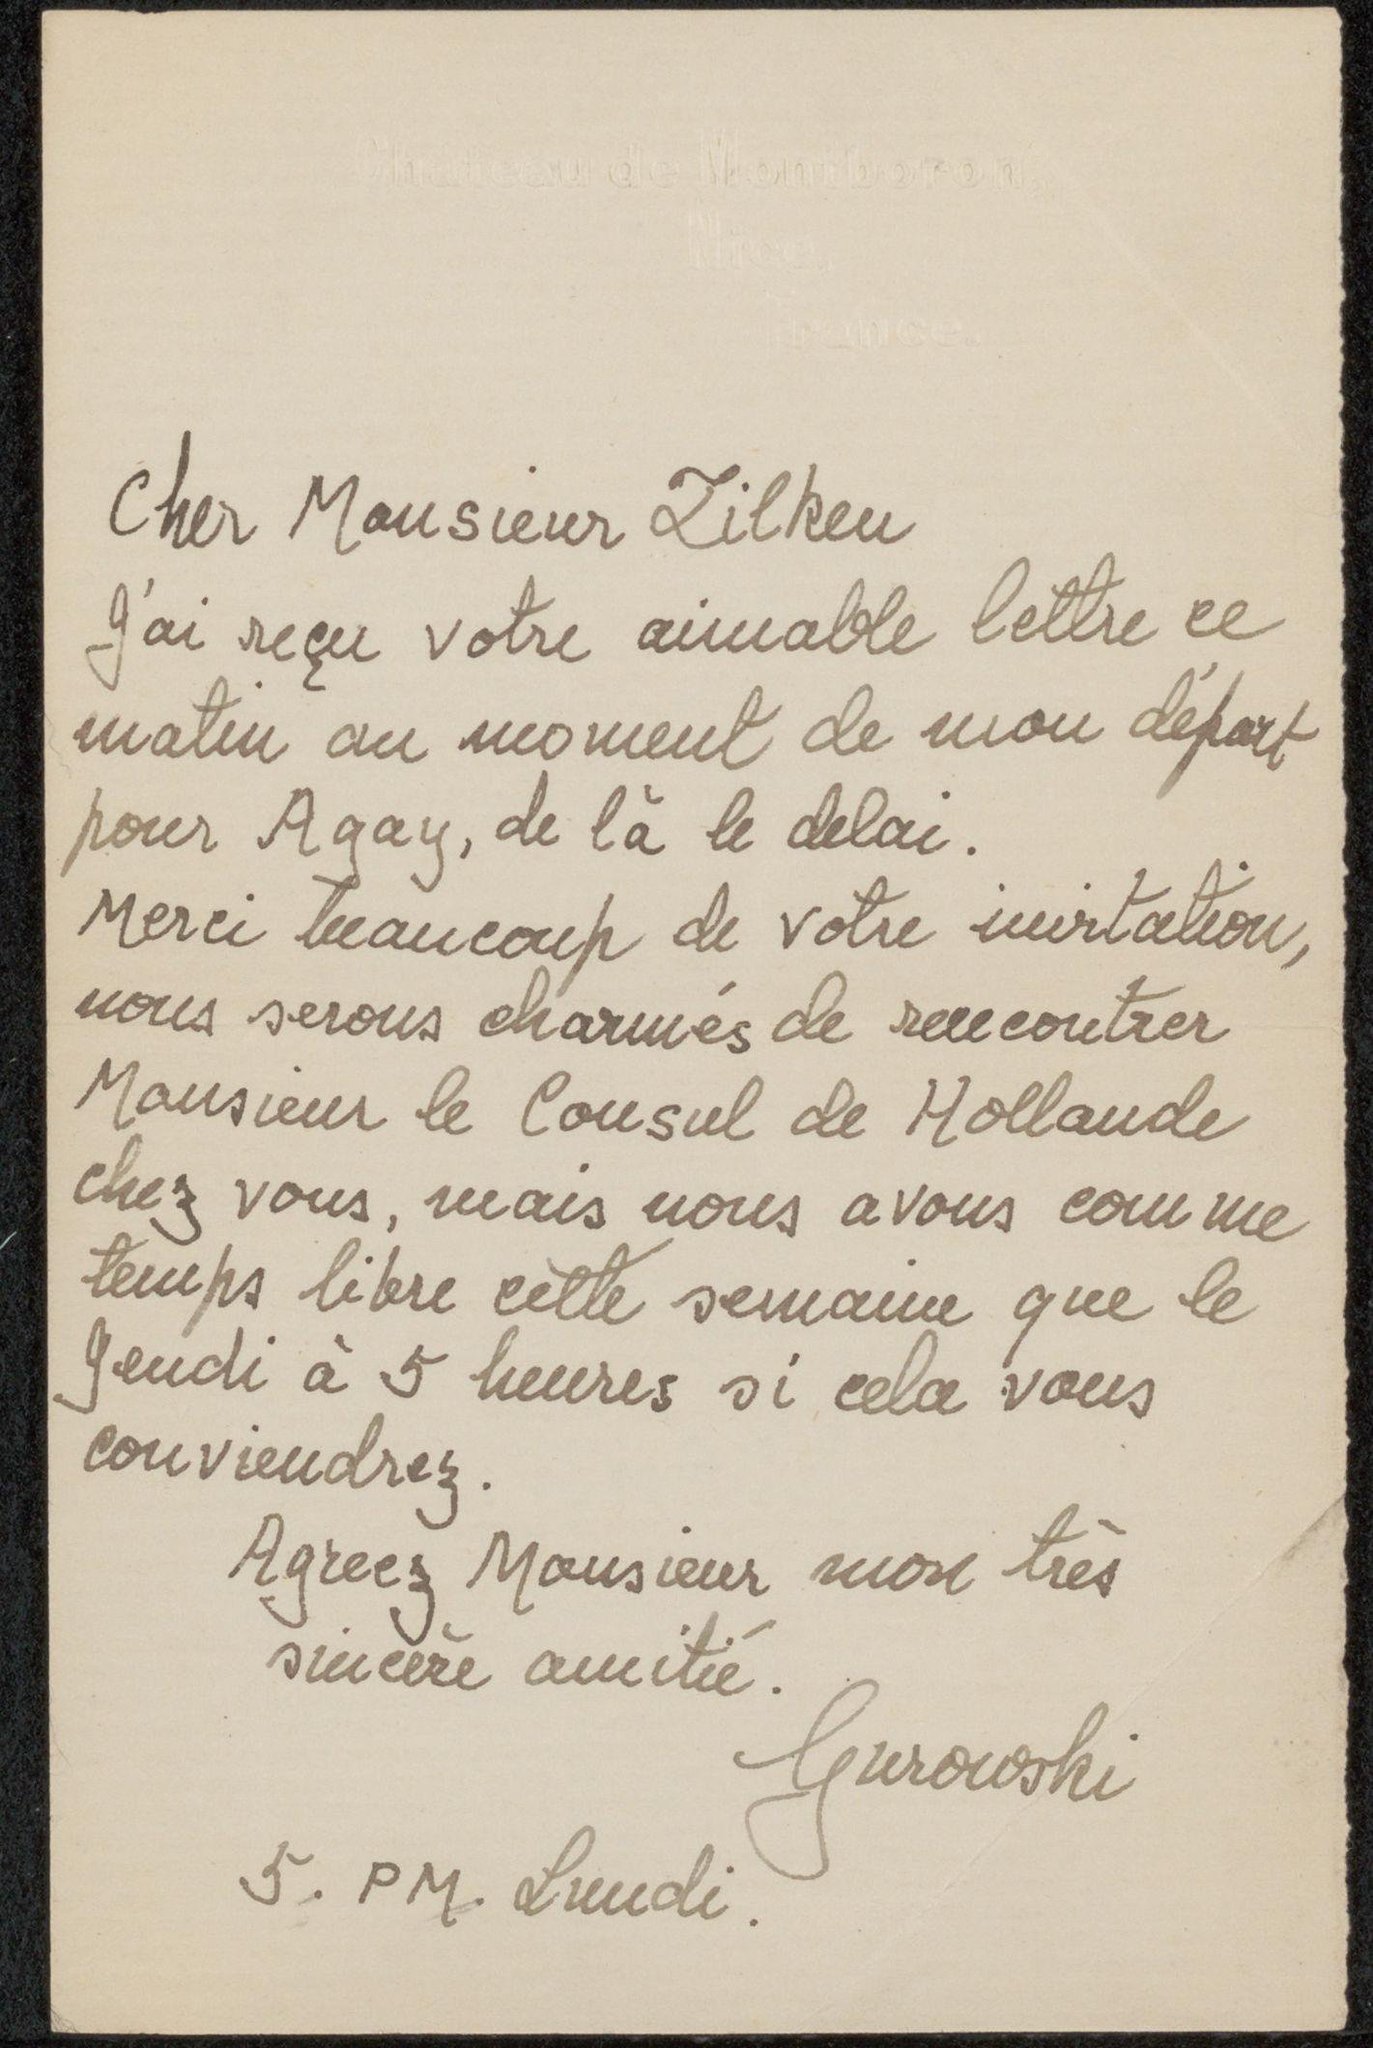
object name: letter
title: Brief aan Philip Zilcken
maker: ch. gurowski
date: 1867-1930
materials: ink, paper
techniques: pen, writing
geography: nice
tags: painter, draughtsman, philip zilcken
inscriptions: collector's mark: ‘RPK’, address: ‘Château de Montboron,/ Nice,/ France.’